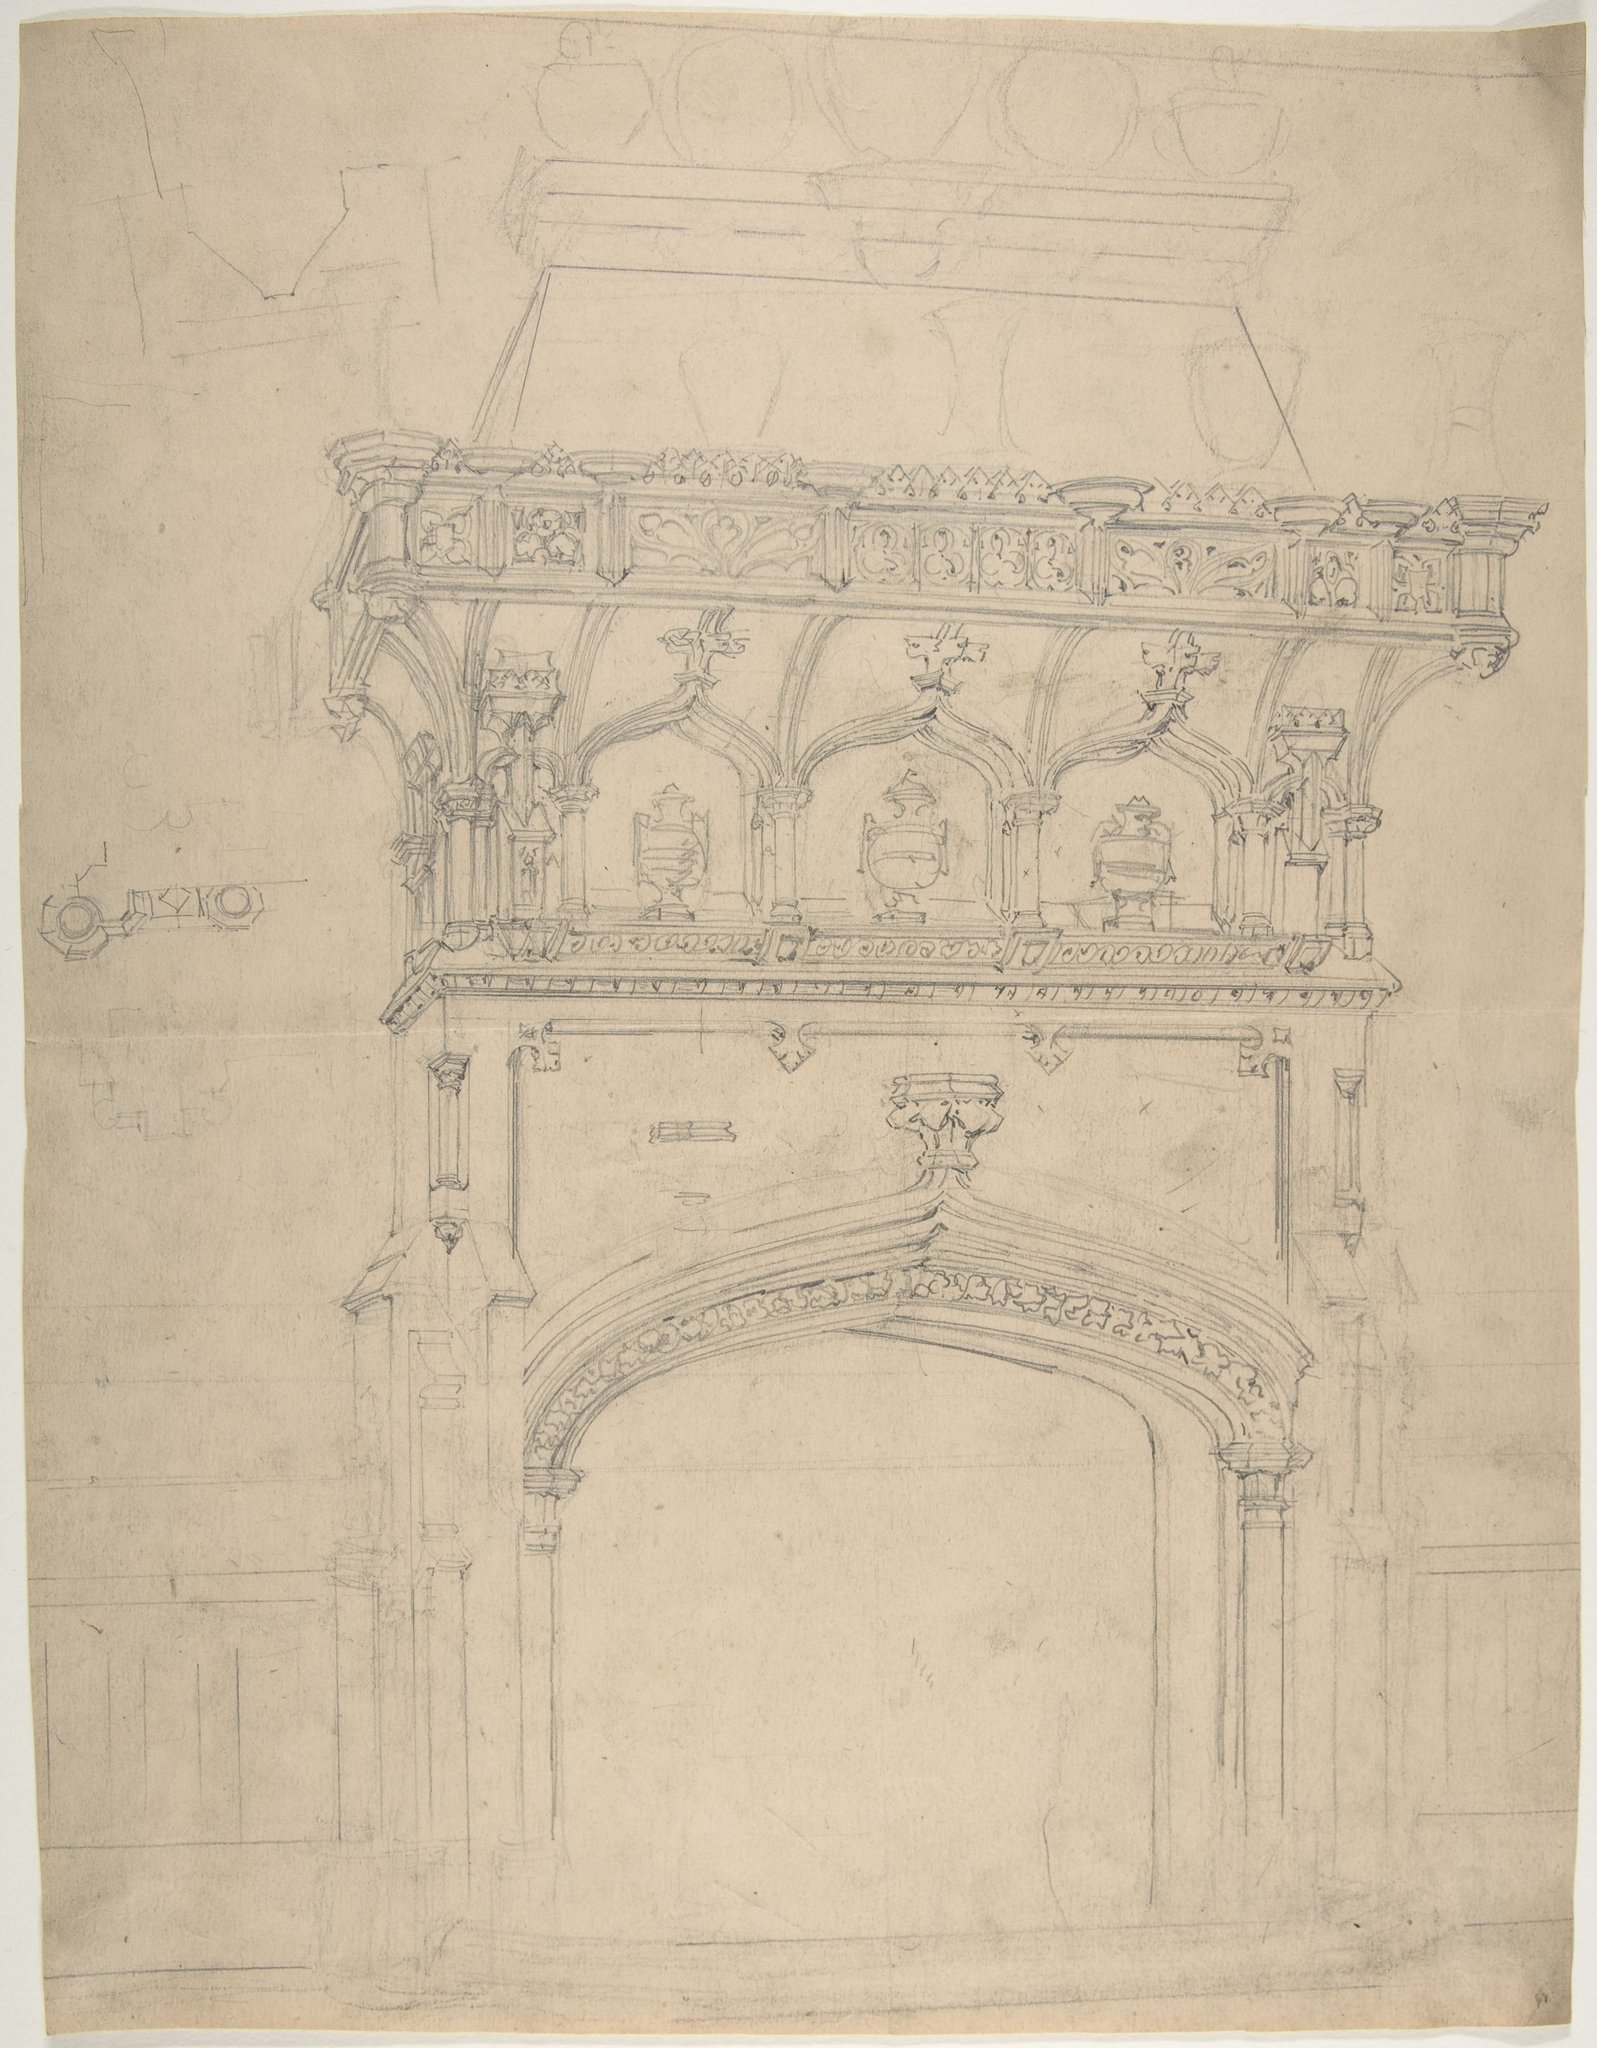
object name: drawing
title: Medieval Chimneypiece Design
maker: anonymous, british, 19th century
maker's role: artist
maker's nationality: british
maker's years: 1800-1900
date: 1801-1900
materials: graphite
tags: architecture